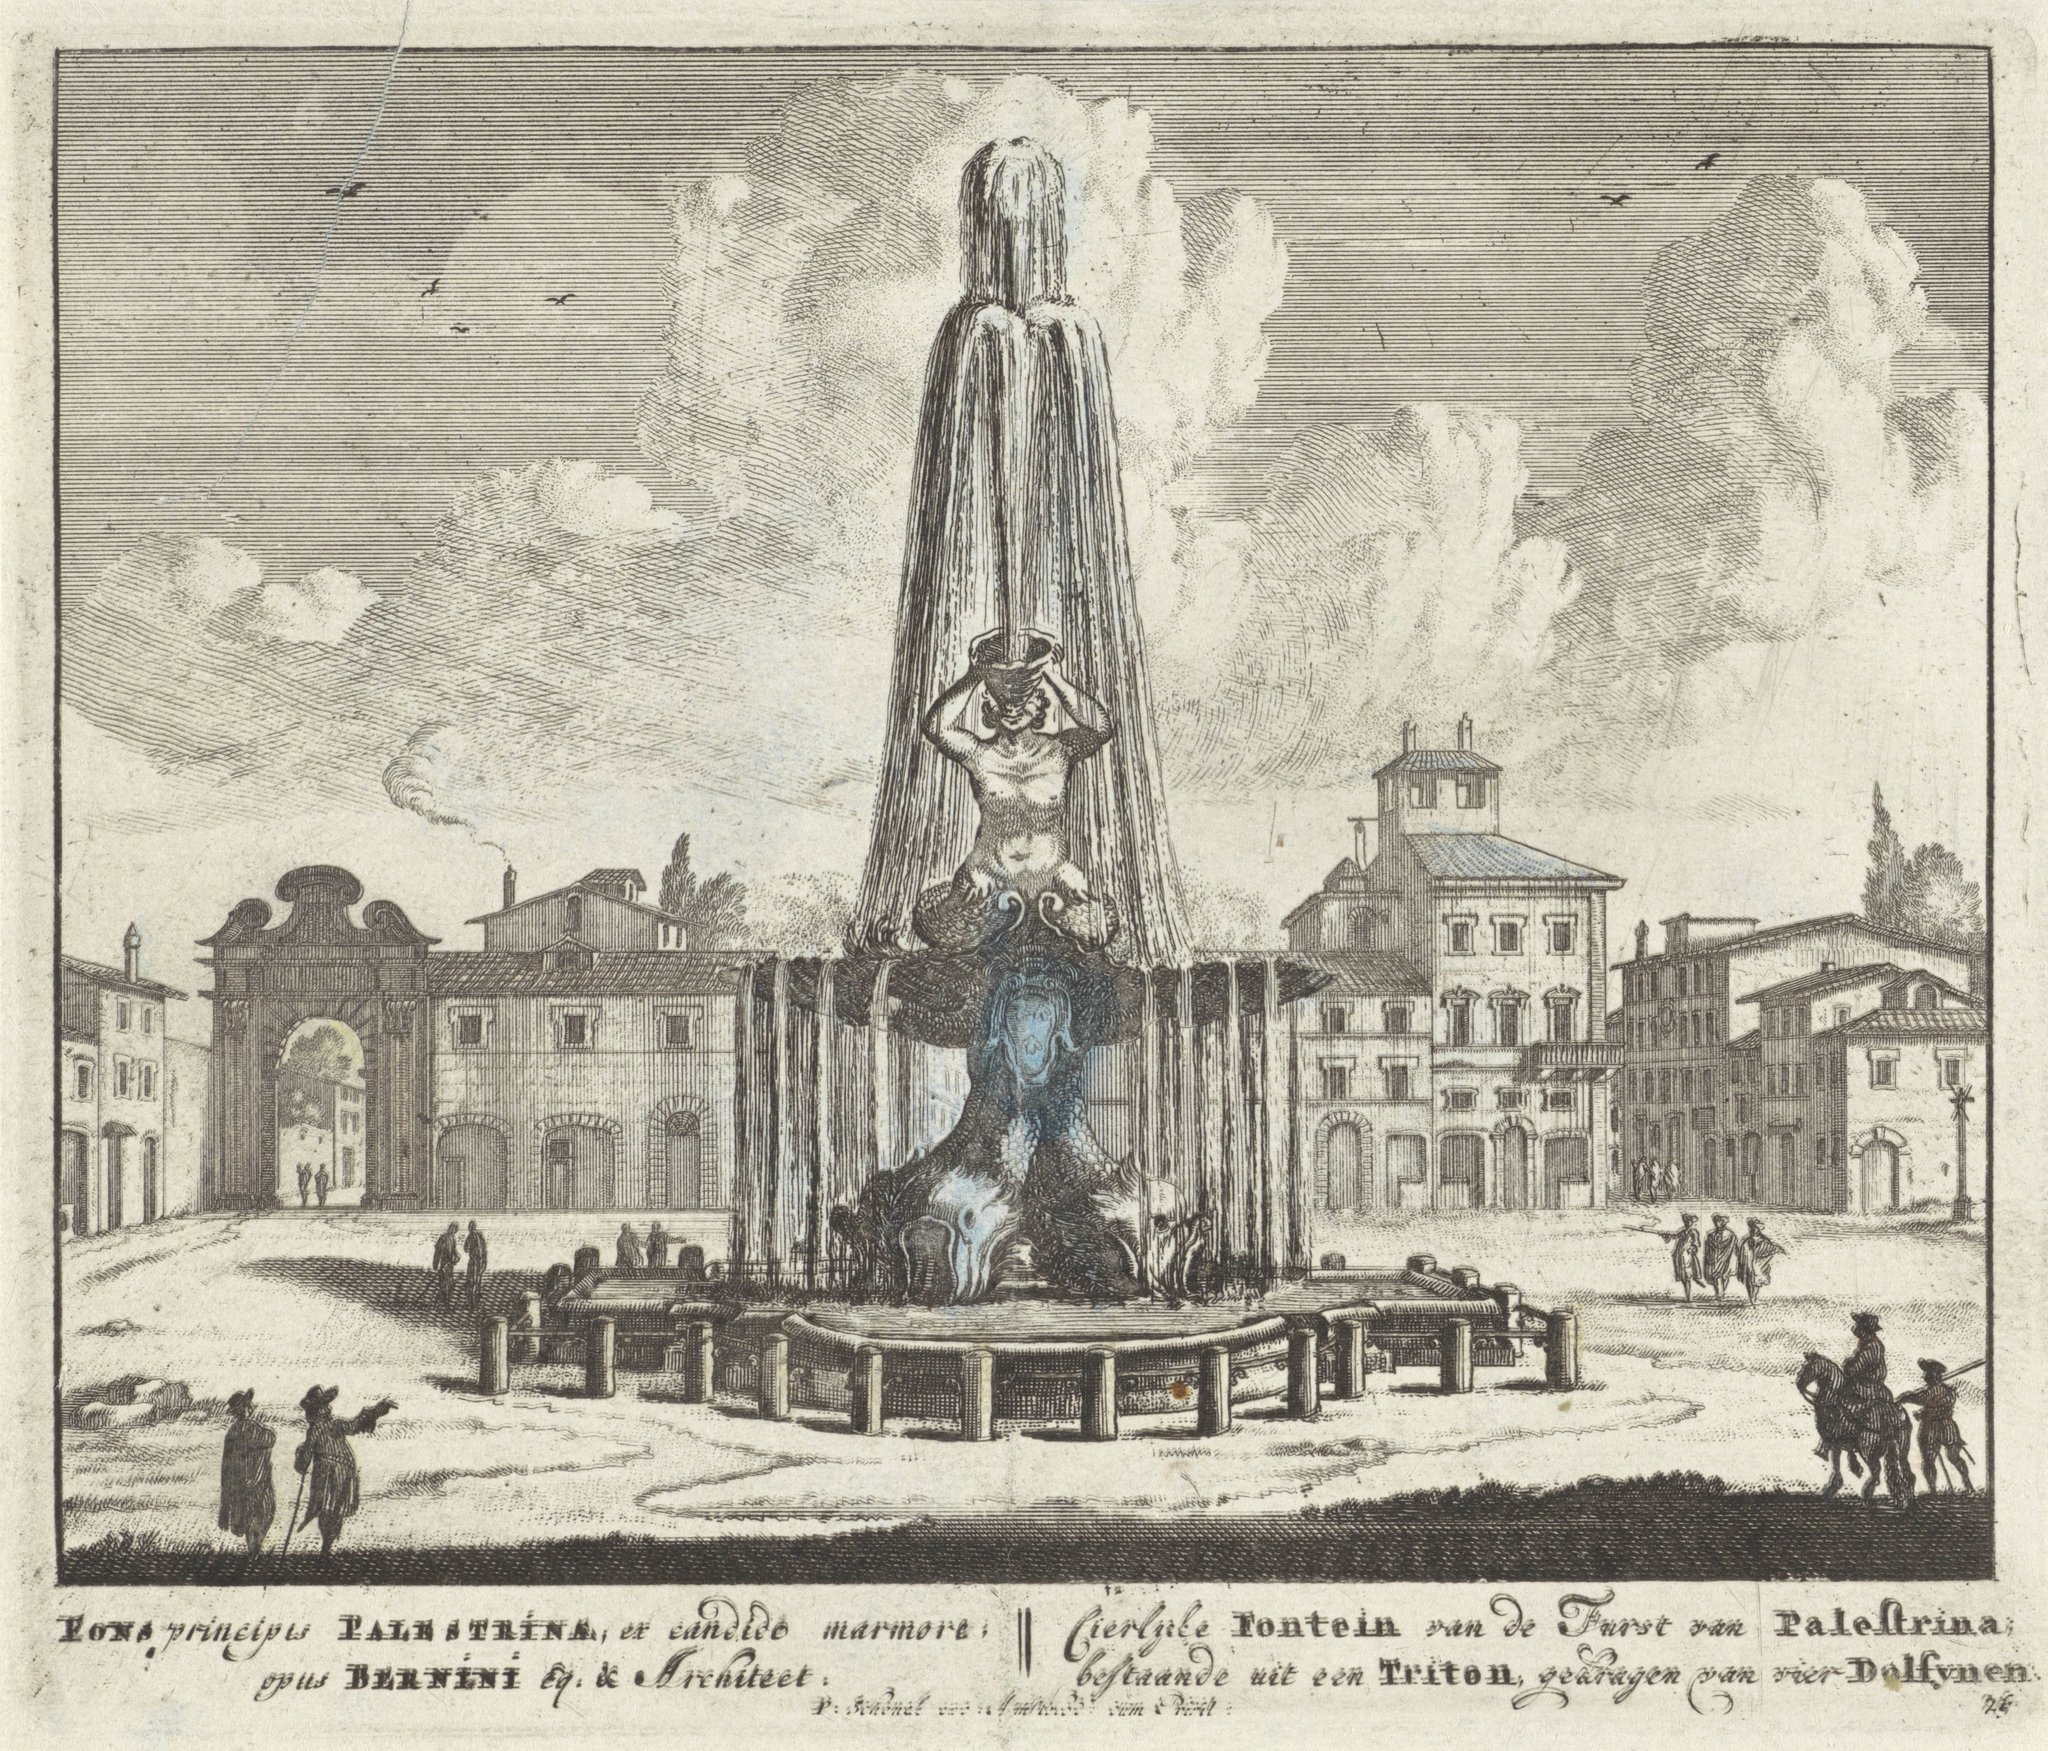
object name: print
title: Gezicht op de Fontana del Tritone te Rome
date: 1675-1711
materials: paper, pencil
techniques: etching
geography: amsterdam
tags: ornamental fountain, rome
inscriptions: collector's mark: Lugt 2228